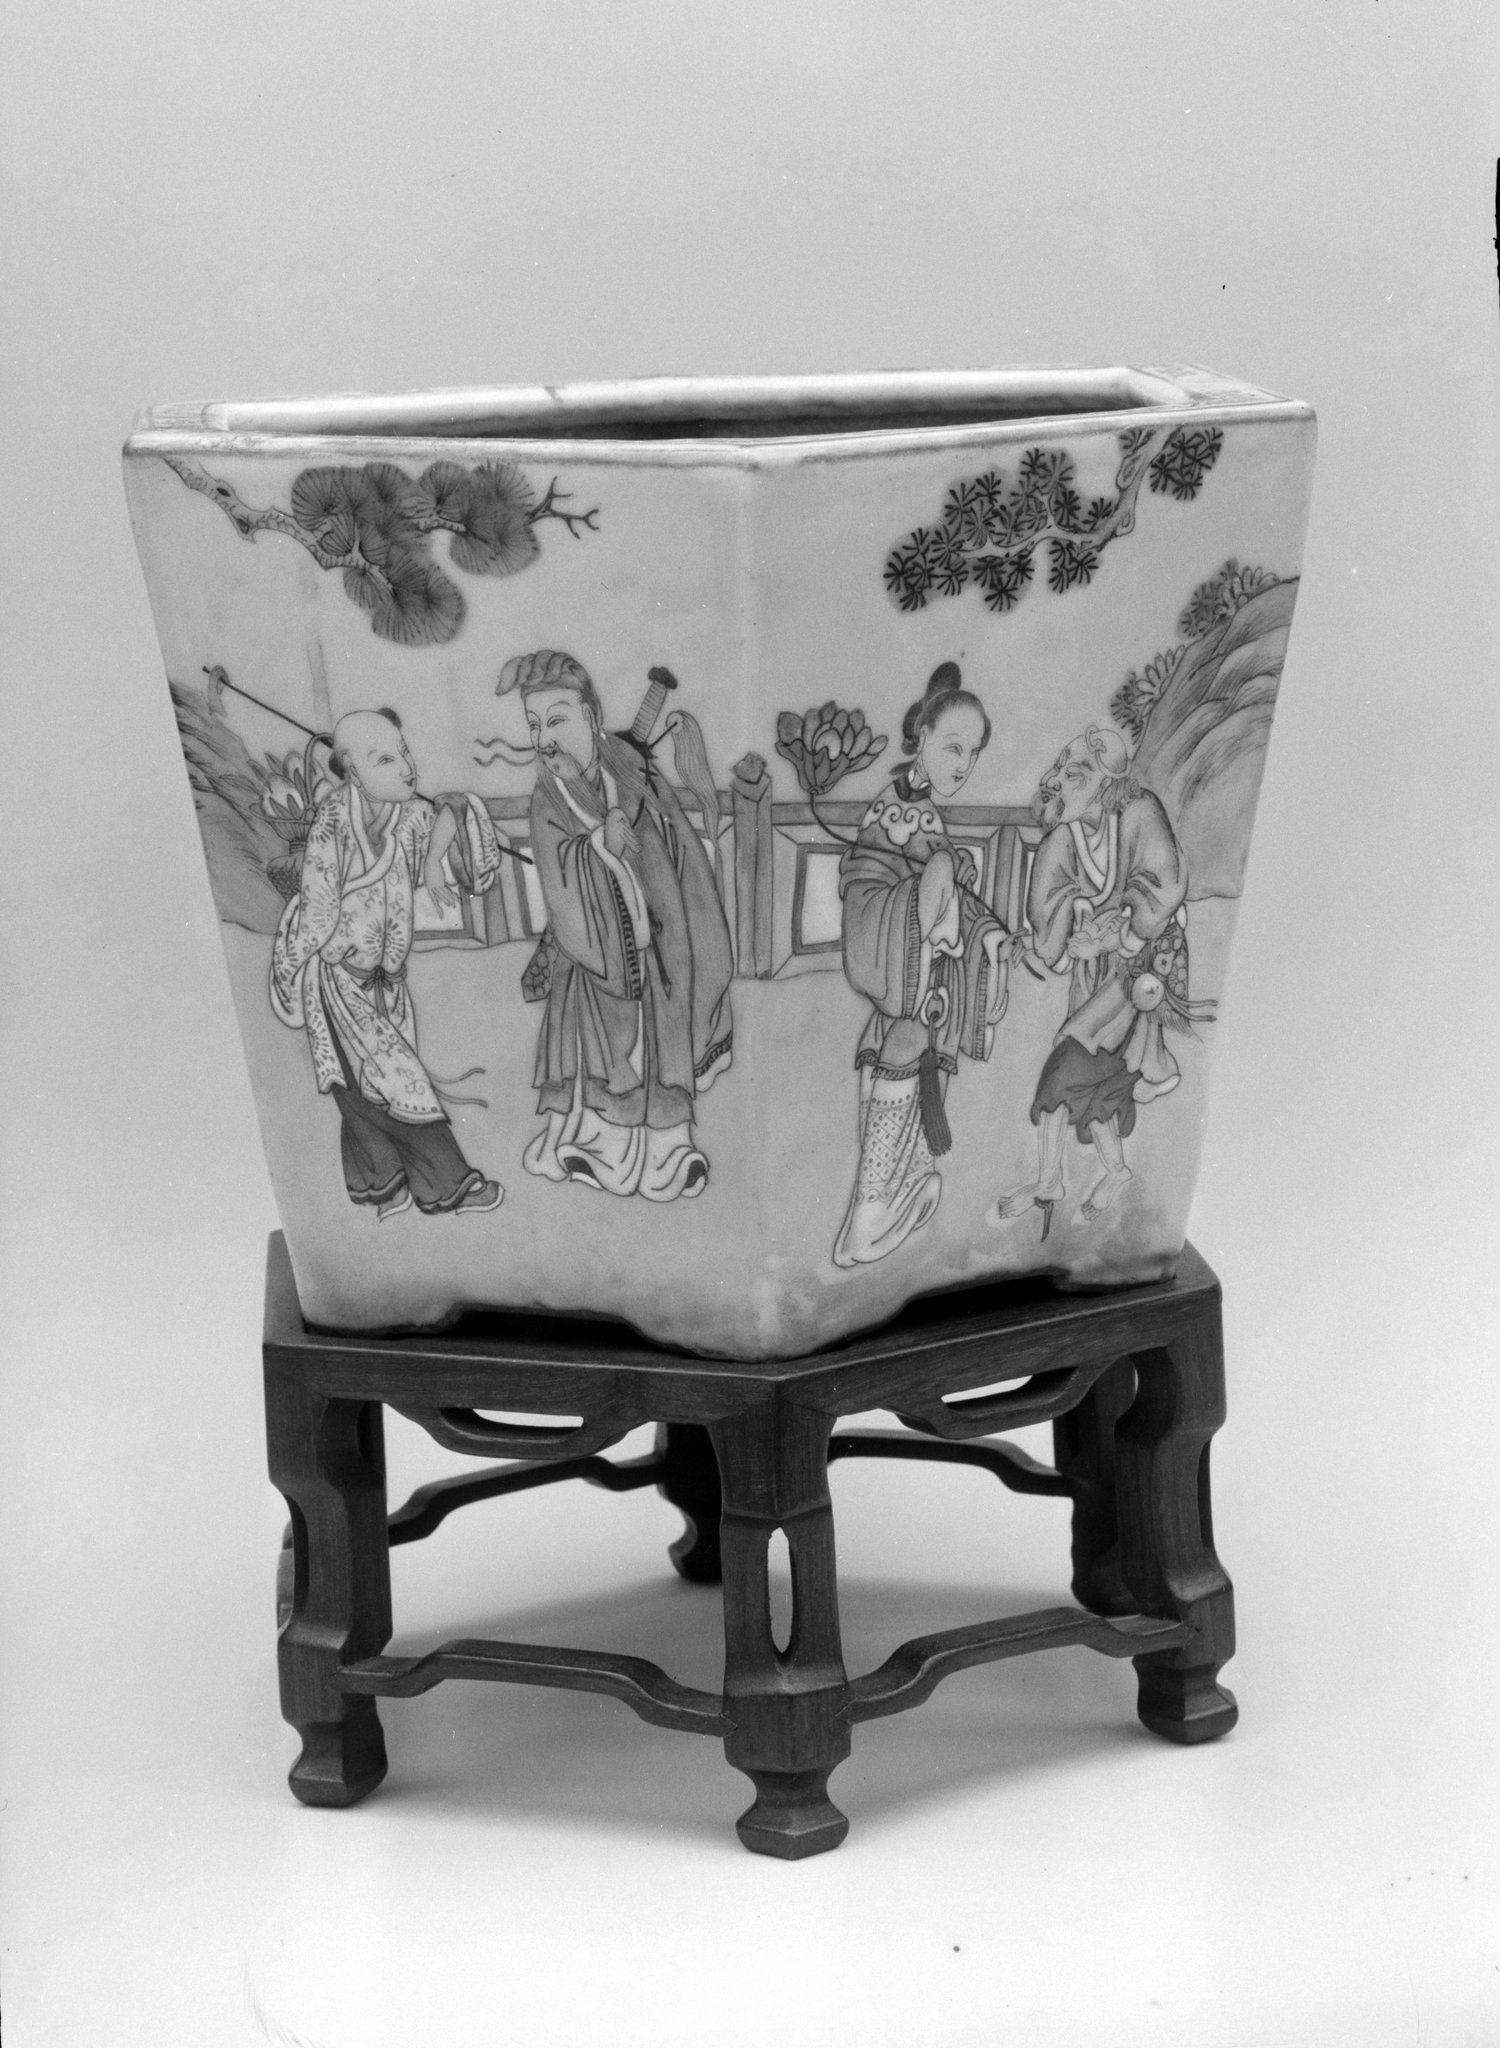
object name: jardinière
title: Jardiniere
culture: chinese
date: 1700-1800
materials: porcelain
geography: china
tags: men,women